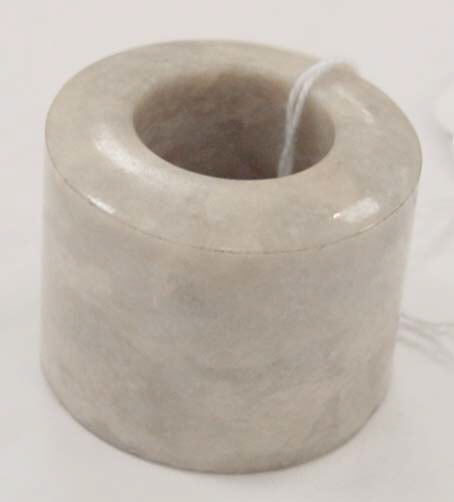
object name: ring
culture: chinese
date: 1801-1900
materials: jade